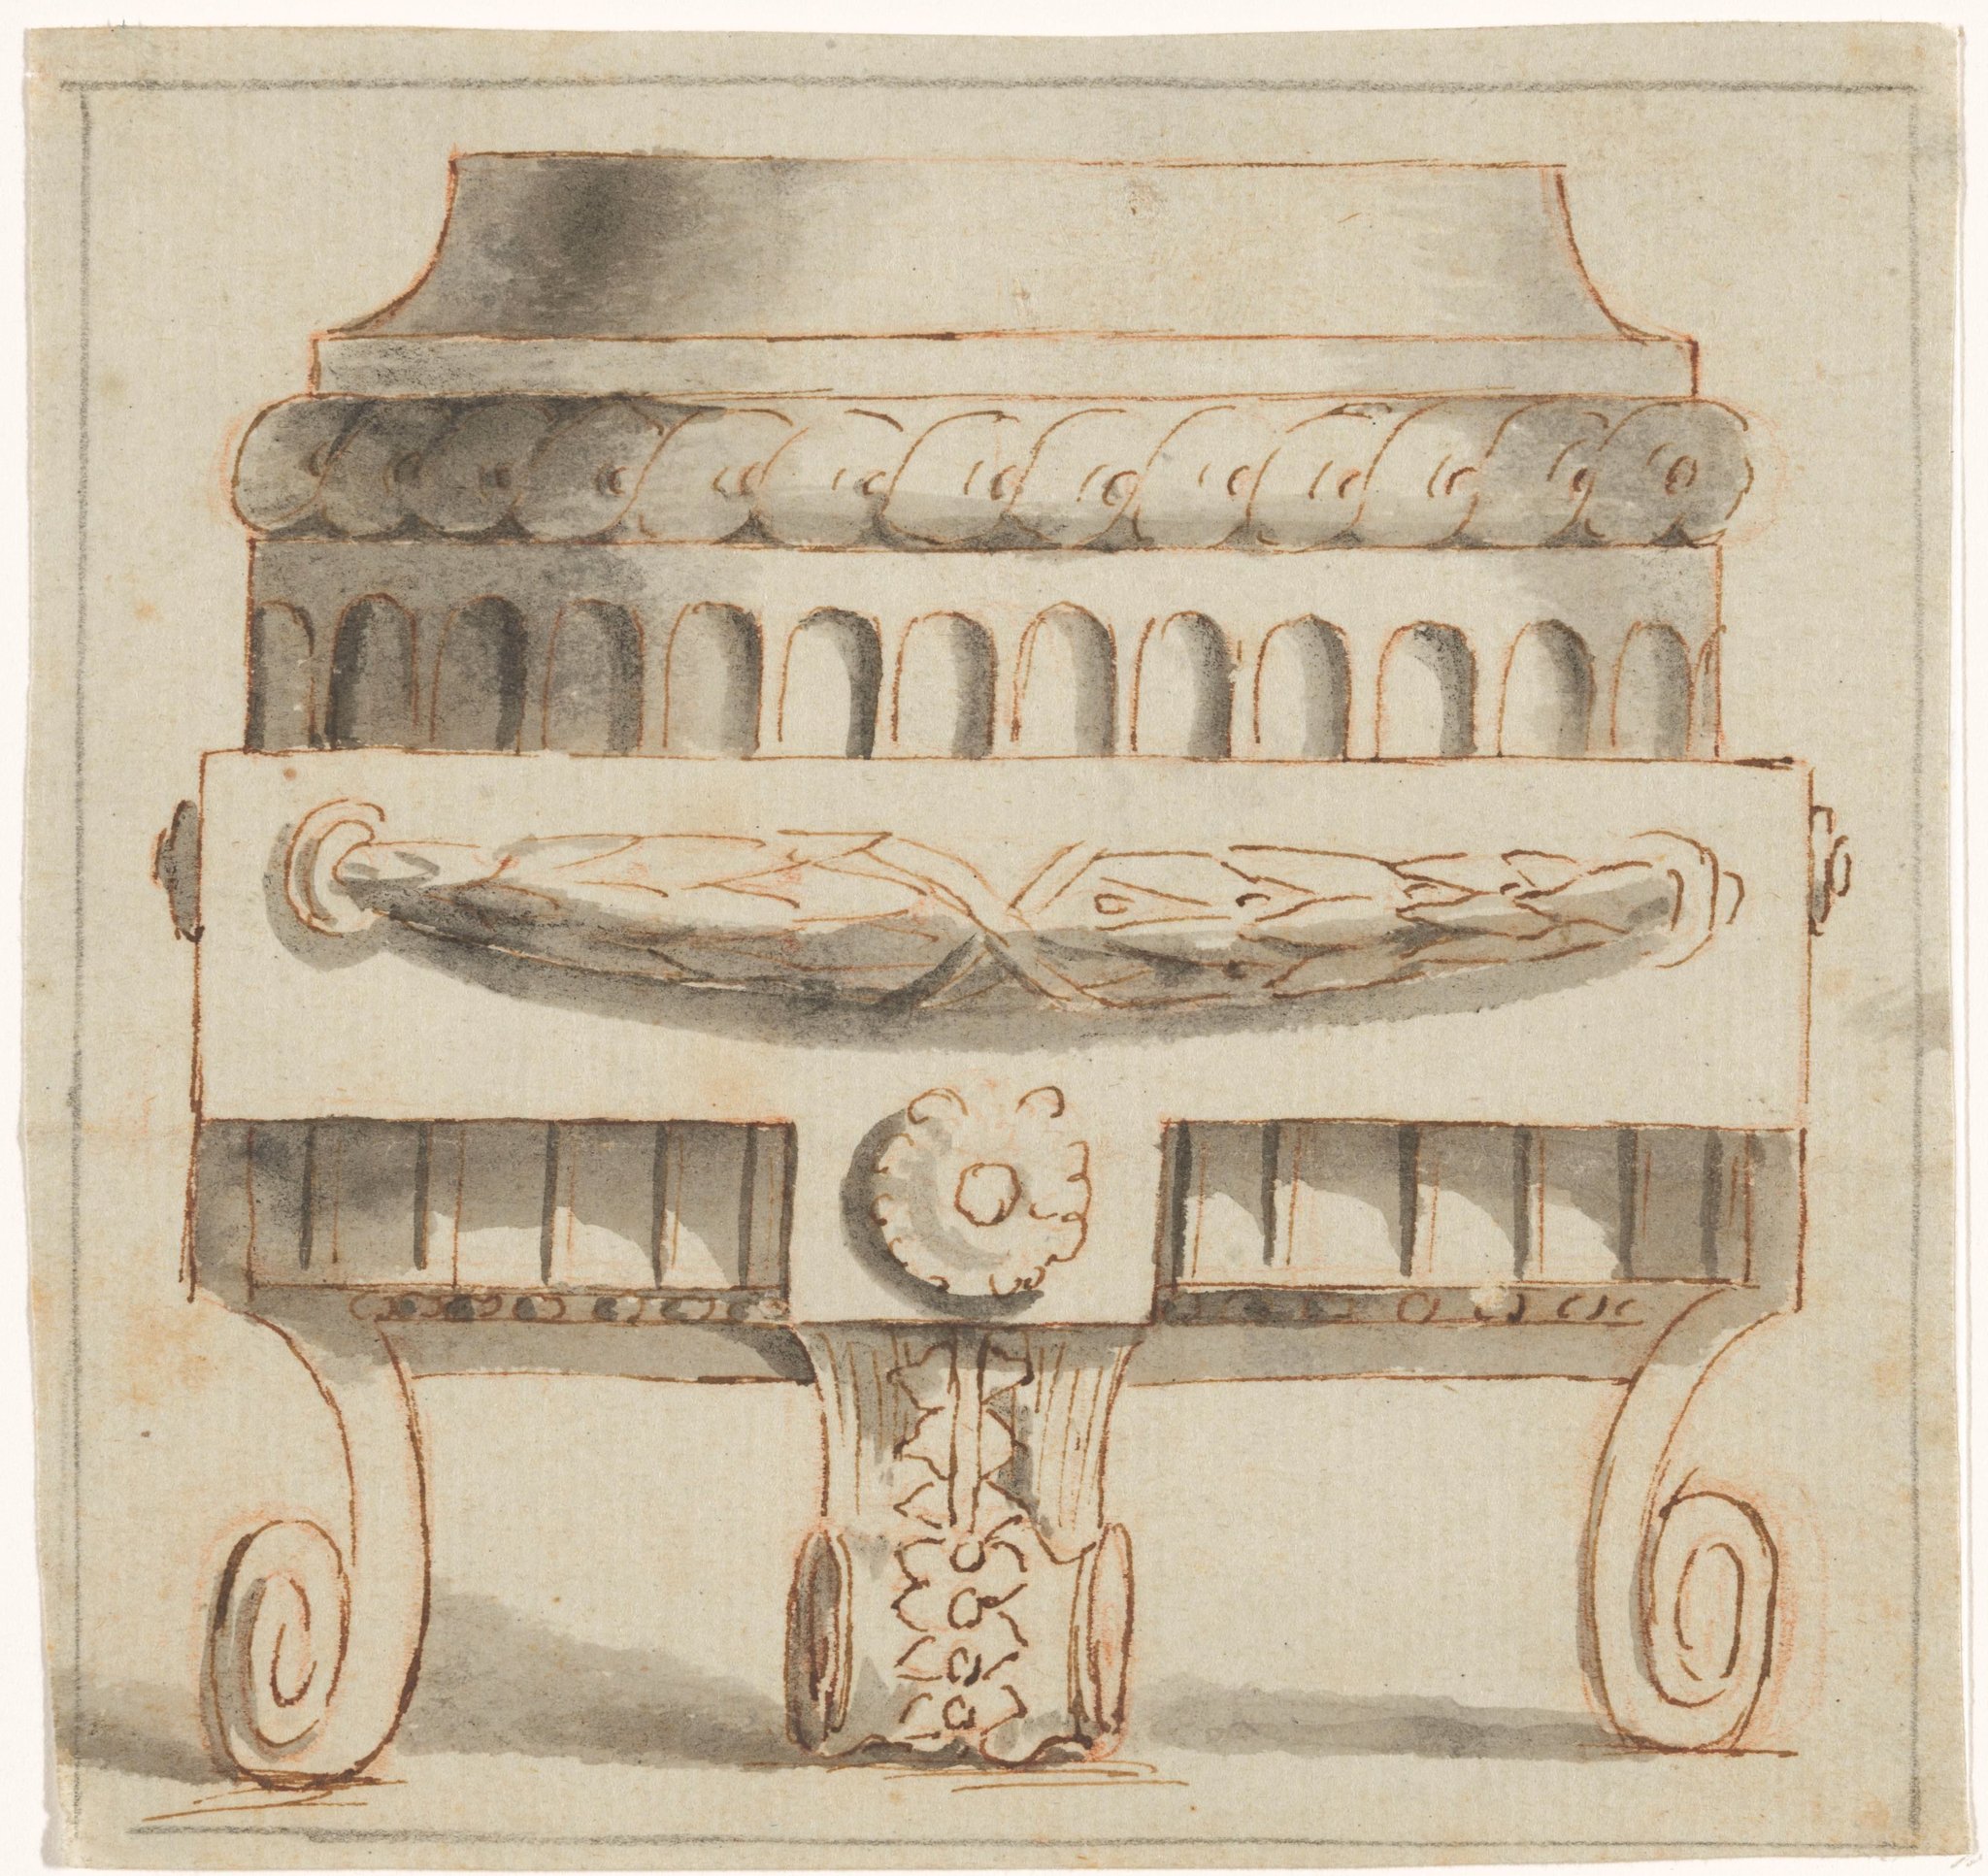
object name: design drawing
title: Ontwerp voor voetstuk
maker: Anonymous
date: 1780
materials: chalk, graphite, ink, paper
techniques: brush, pen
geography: antwerp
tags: furniture and household effects